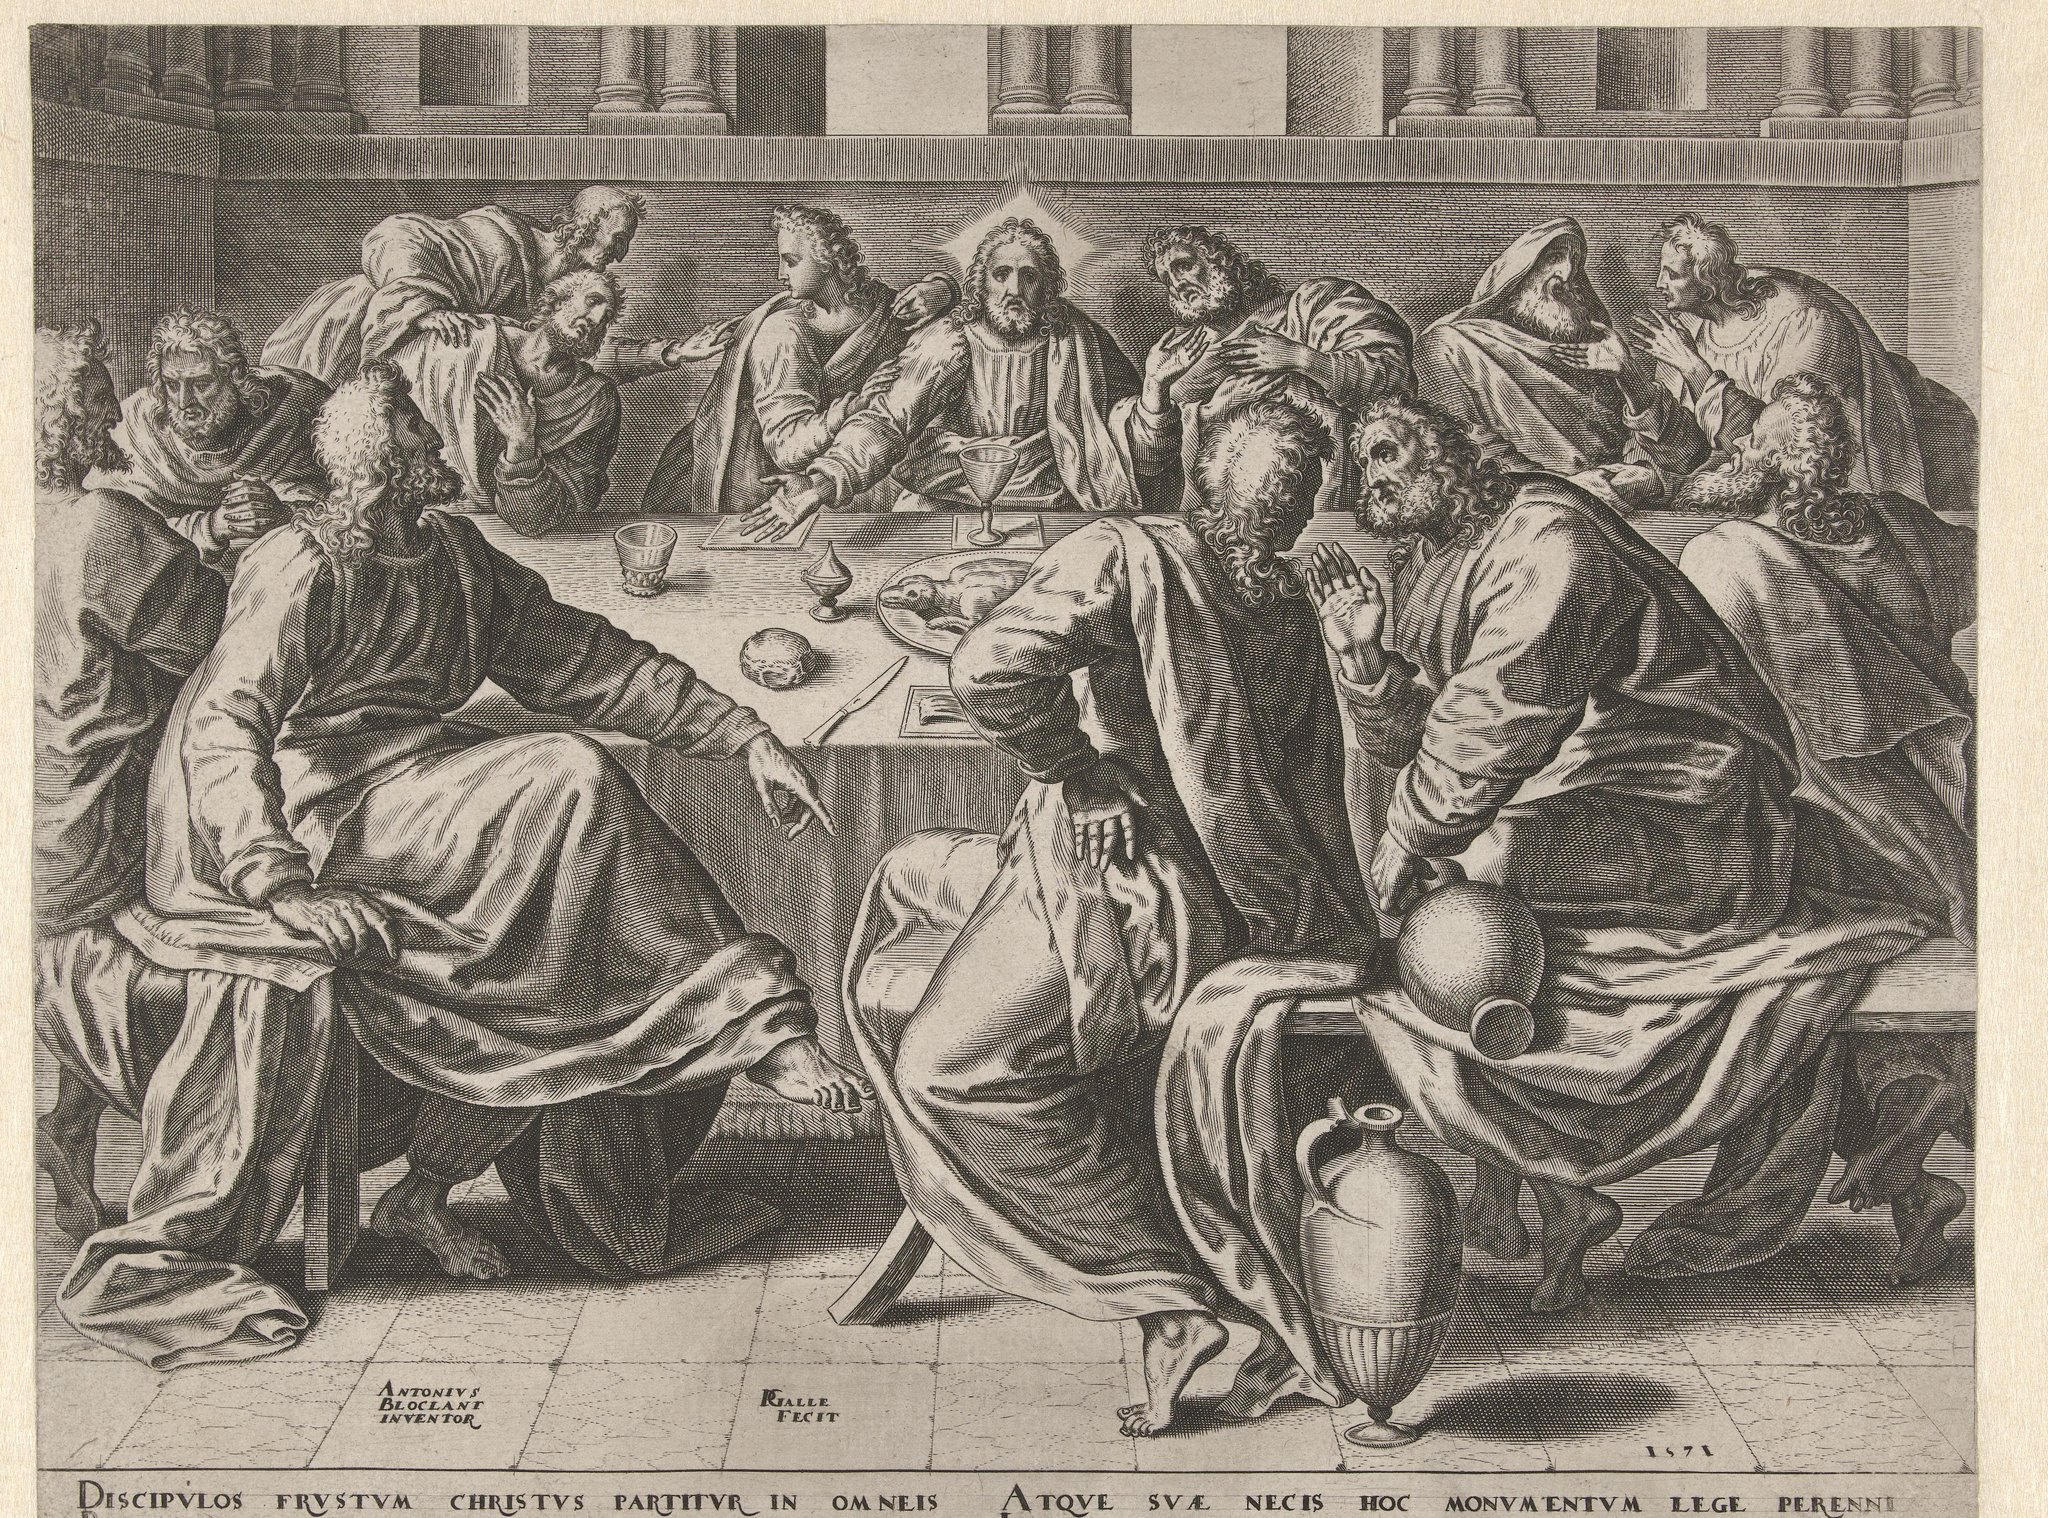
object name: print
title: Laatste Avondmaal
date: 1571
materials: paper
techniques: engraving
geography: antwerp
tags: last supper (in general) (matthew 26:21-35; mark 14:18-31; luke 22:3, 22:15-23; john 13:21-38)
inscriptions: collector's mark: Lugt 2228